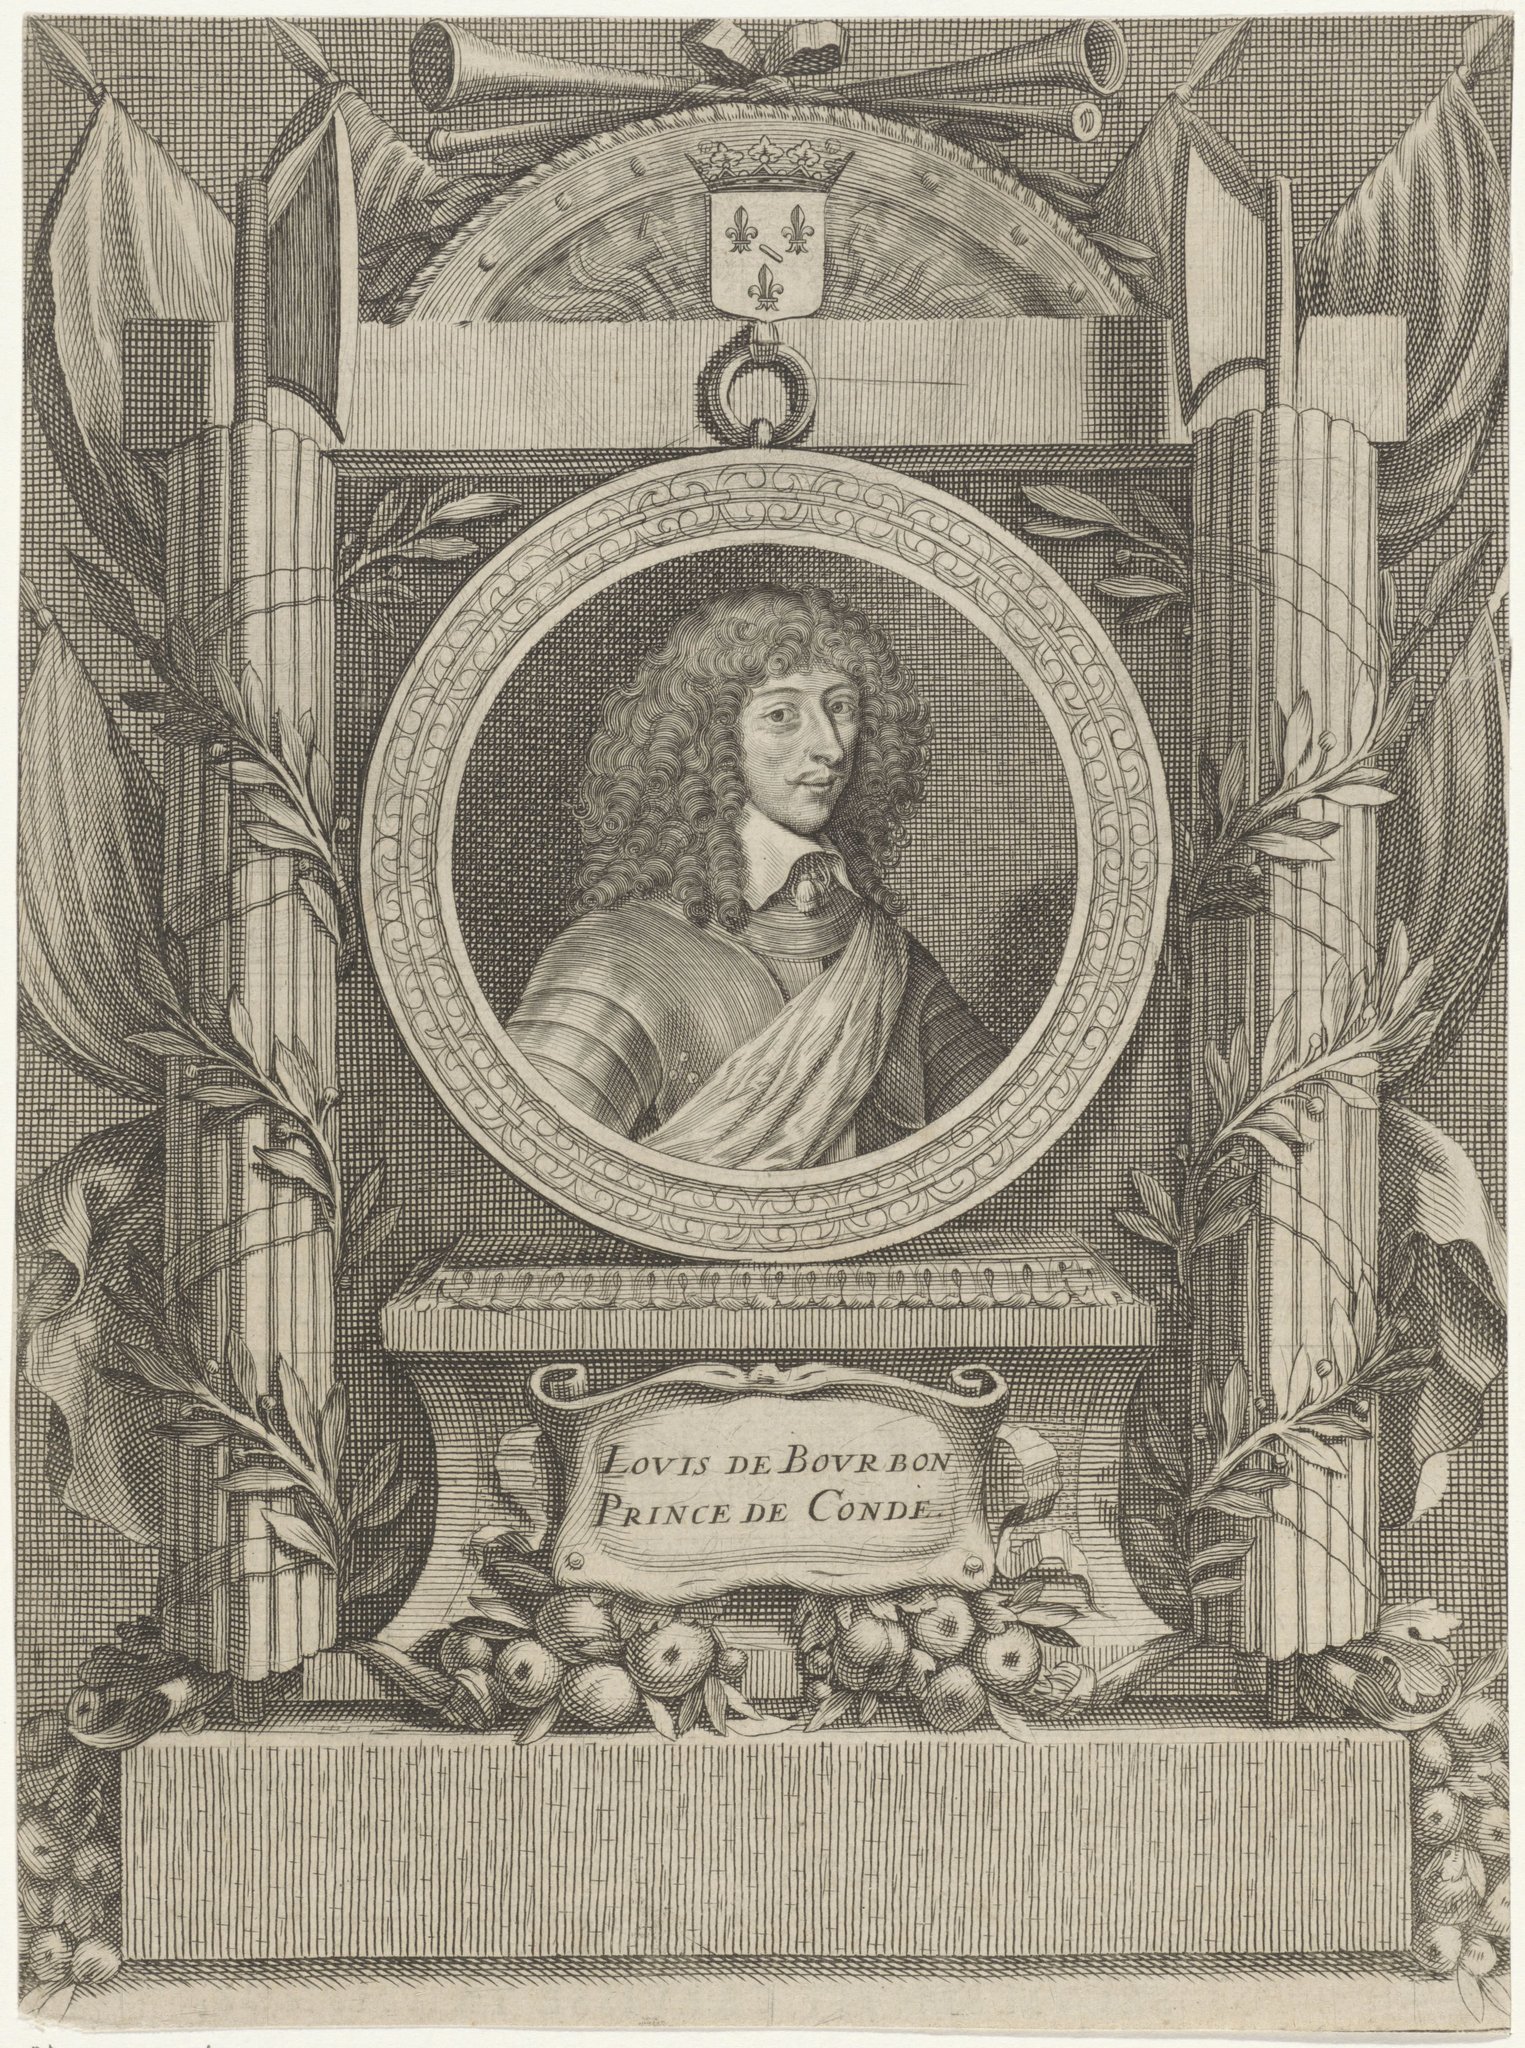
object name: print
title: Portret van Lodewijk II van Bourbon-Condé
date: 1649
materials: paper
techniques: engraving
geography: paris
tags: lodewijk ii de bourbon-condé (hertog van enghien), lodewijk xiii (koning van frankrijk)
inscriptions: collector's mark: Lugt 2228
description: Boekillustratie in: Estienne, Henry. Devises des roys, princes et generaux d'armees qui ont assiste ou servy Louis le Juste combattant. In: Les Triomphes de Louis le Juste XIII. Parijs: A. Estienne, 1649.